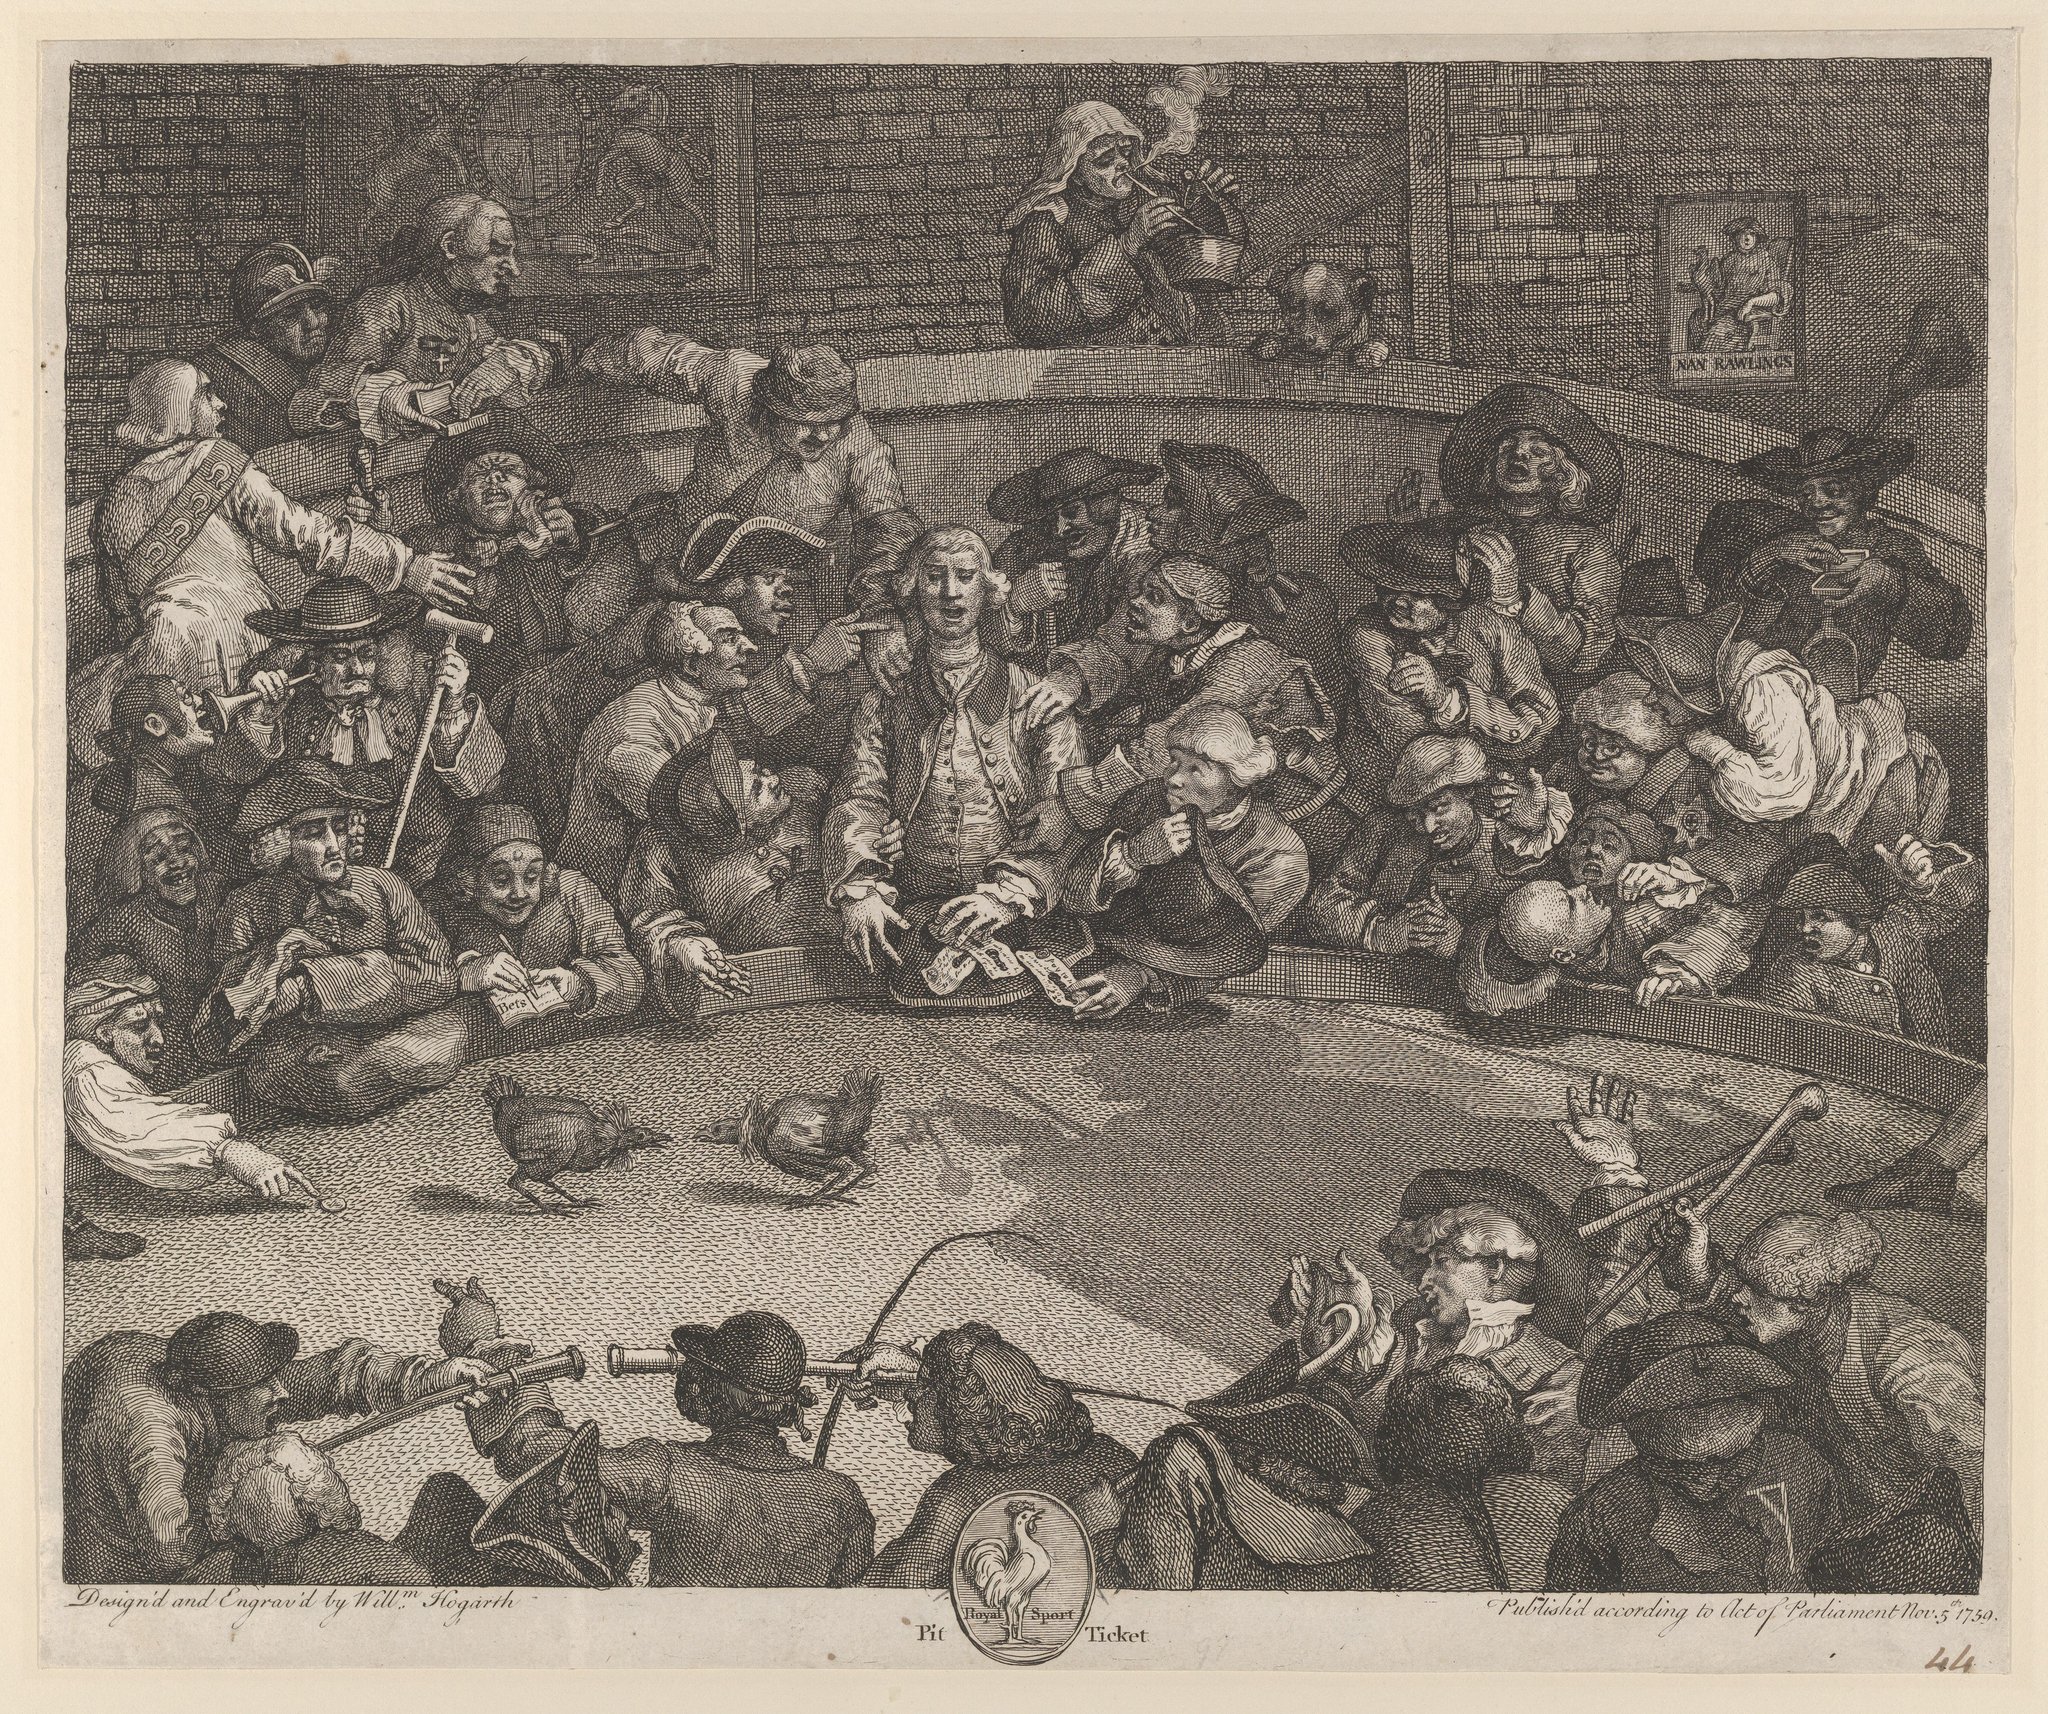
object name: print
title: The Cockpit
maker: william hogarth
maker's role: artist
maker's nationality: british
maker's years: 1697-1764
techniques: engraving, etching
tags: birds,men,spectators,coat of arms